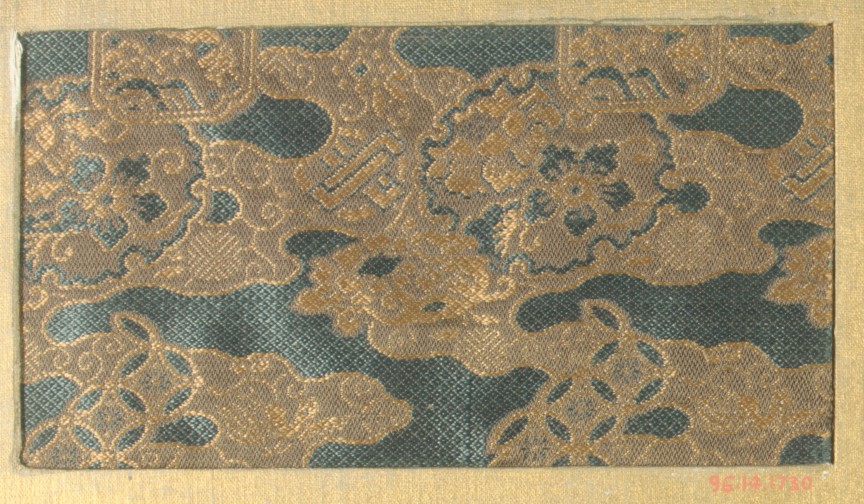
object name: piece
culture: japanese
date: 1701-1900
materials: silk